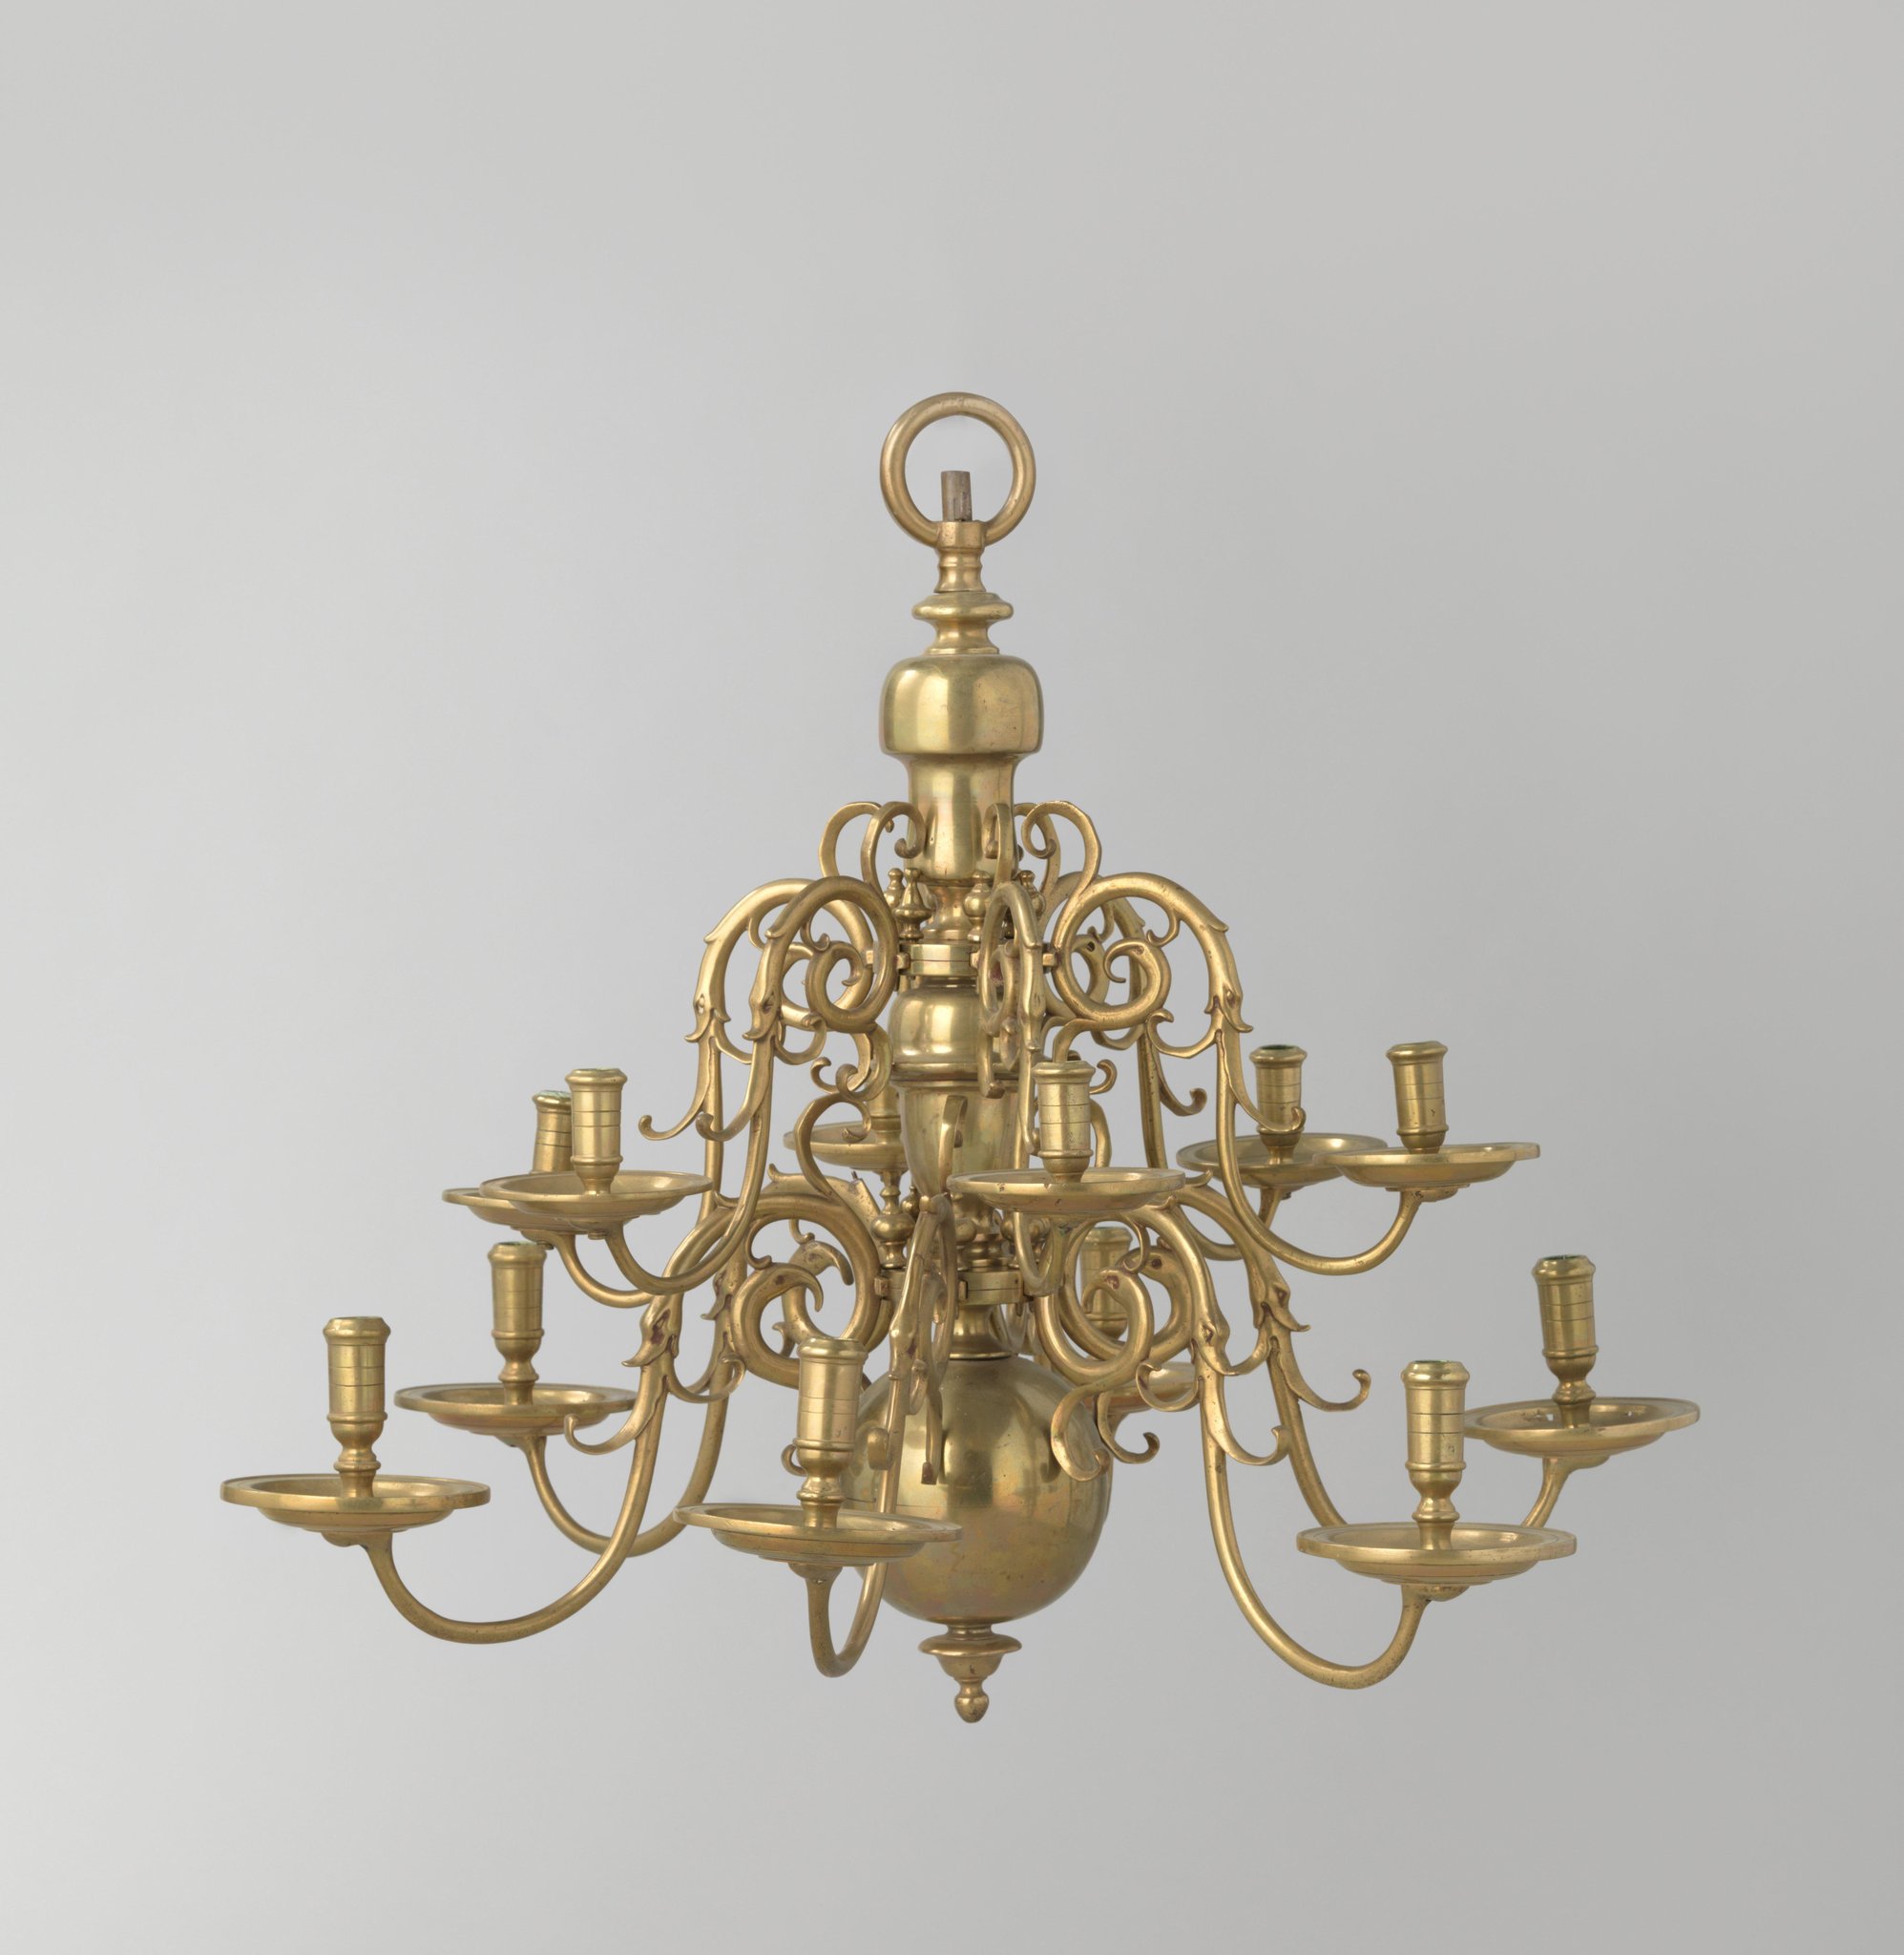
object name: chandelier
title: Arm met kaarsenhouder van kaarsenkroon van twee hoogten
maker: Anonymous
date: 1800-1875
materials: brass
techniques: casting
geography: netherlands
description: Kaarsenarm behorende bij een messing kaarsenkroon van twee hoogten. De S-vormige arm heeft een krul bij de aanzet, halverwege een dolfijnenkop en gaat naar buiten toe over in het platte verdikking met een schroefgat. Daarin is de kaarsenhouder met de vetvanger vastgezet. De vetvanger is aan de onderzijde geribd geprofileerd rond de opening en heeft een naar onder en naar boven toe iets uitstekend randje en is versierd met gegroefde forse ringen. De cylindrische kaarsenhouder heeft een geprofileerde en een weinig uitstekende rand, twee gegroefde ringen, een rib en een geprofileerd holrond onderstuk, dat overgaat in een uitsteeksel met een schroefdraad met een centergat. Dit is de eerste arm van de onderste standring, genummerd met 1 ronde punt.